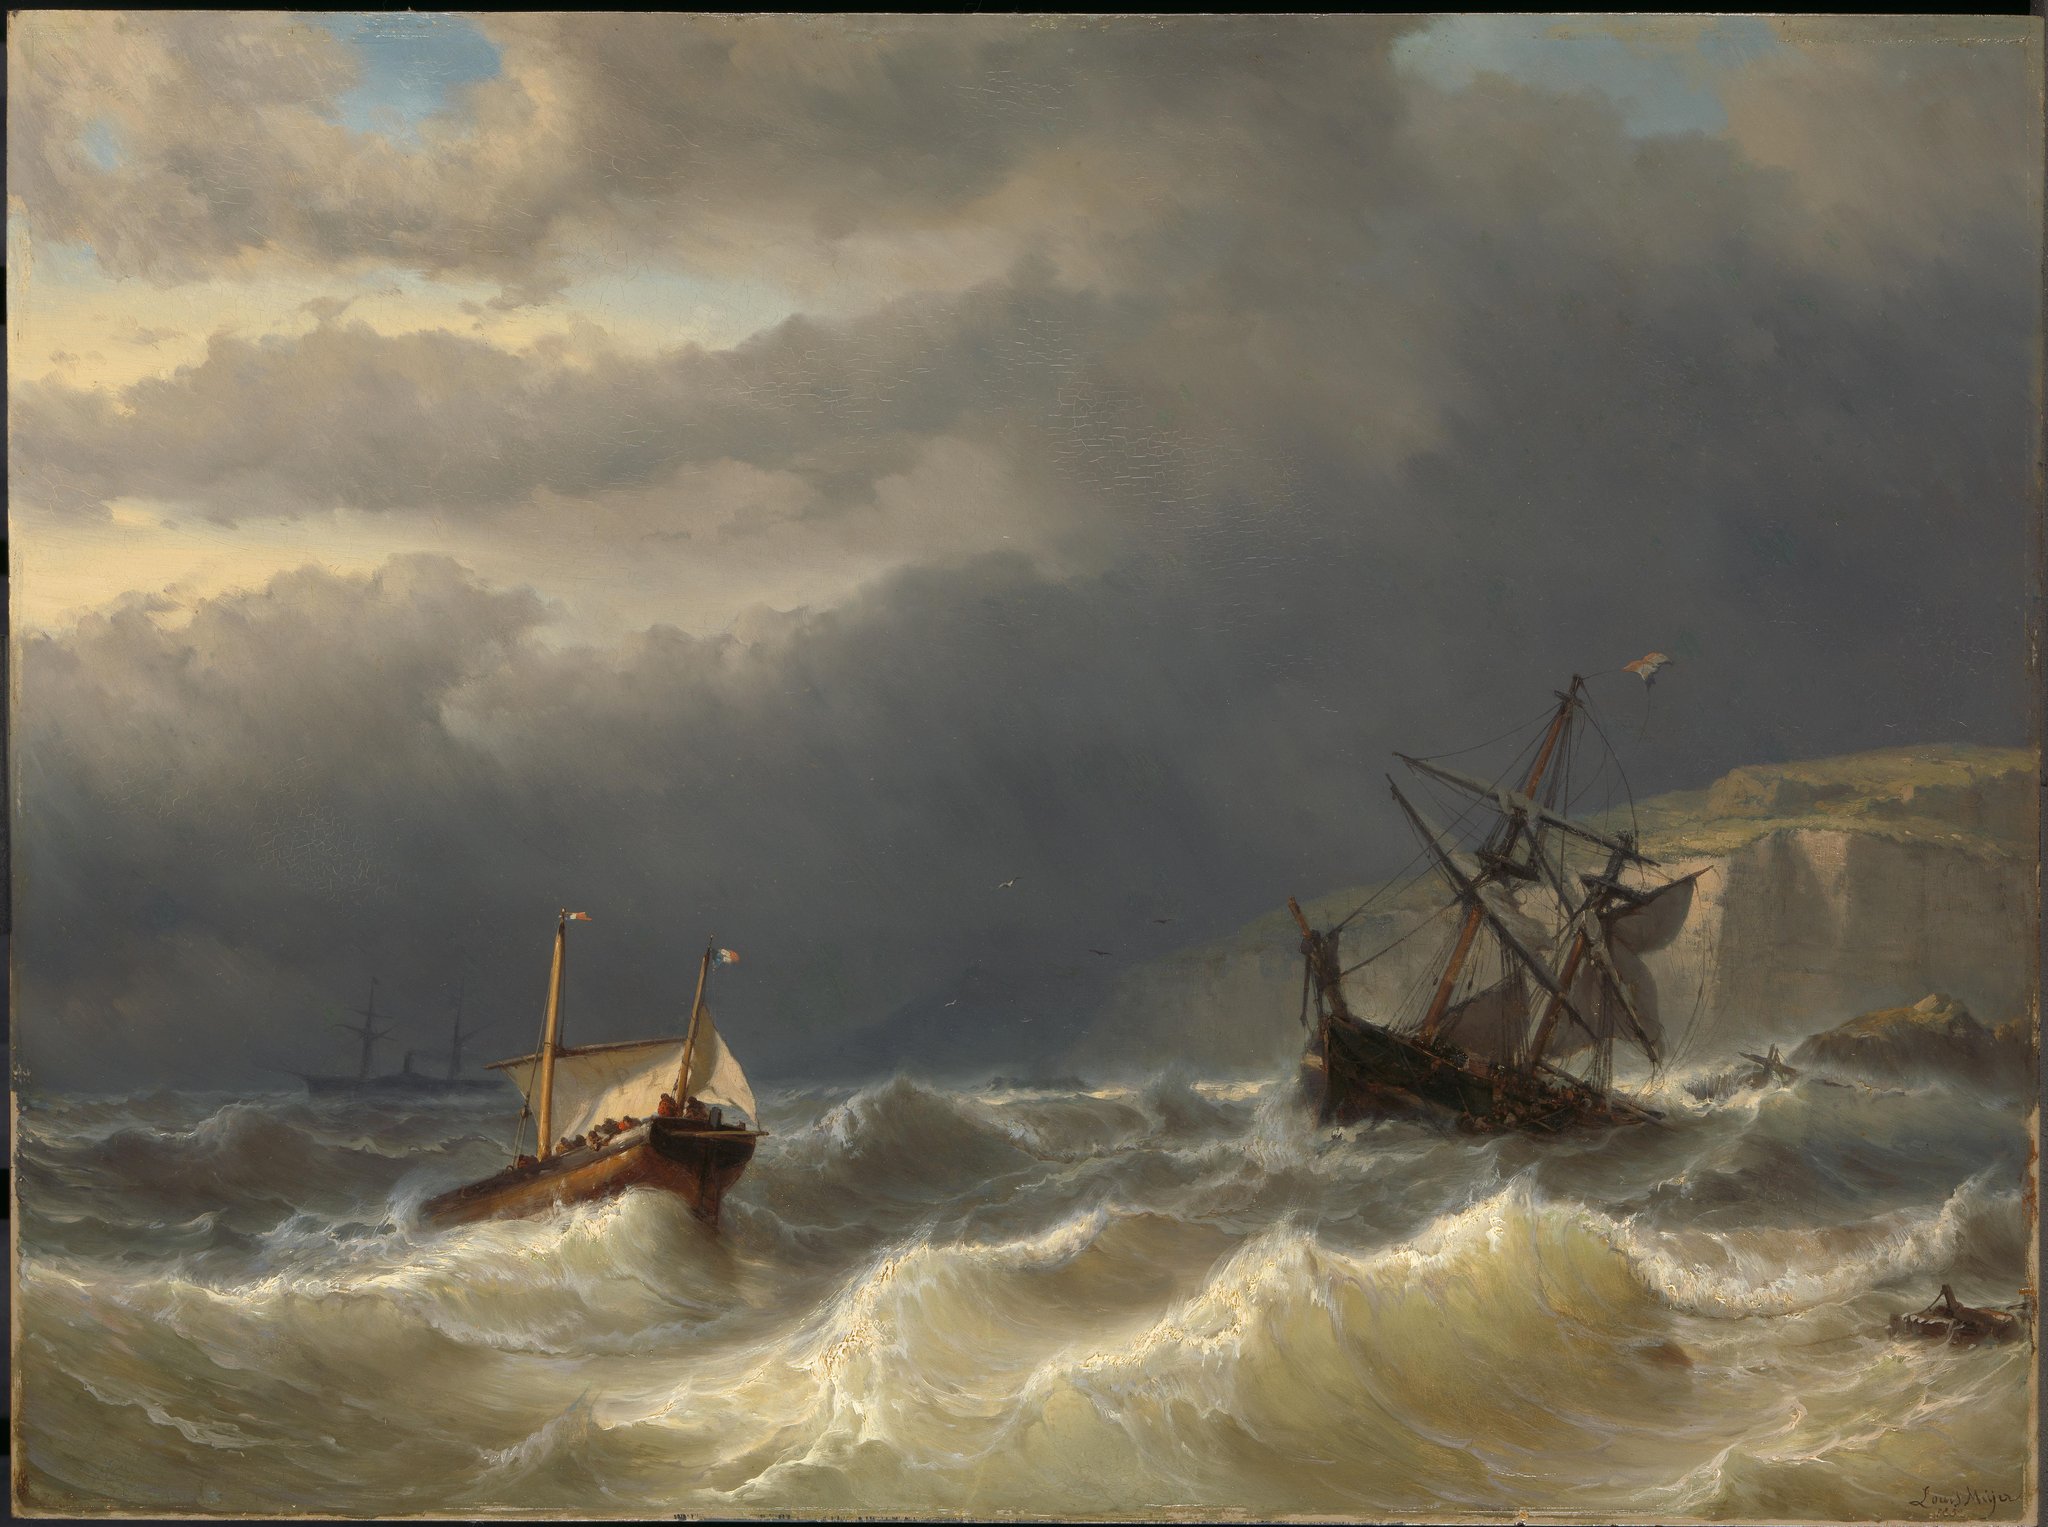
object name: painting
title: Storm in the Strait of Dover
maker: louis meijer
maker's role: draughtsman, painter, print maker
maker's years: 1809-1866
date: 1819-1866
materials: oil, panel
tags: sailing-ship, sailing-boat, rocky coast, storm at sea, english channel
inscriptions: signature: ‘Louis Meyer’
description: Storm in het Nauw van Calais. Schepen op zee nabij een kust tijdens een storm.